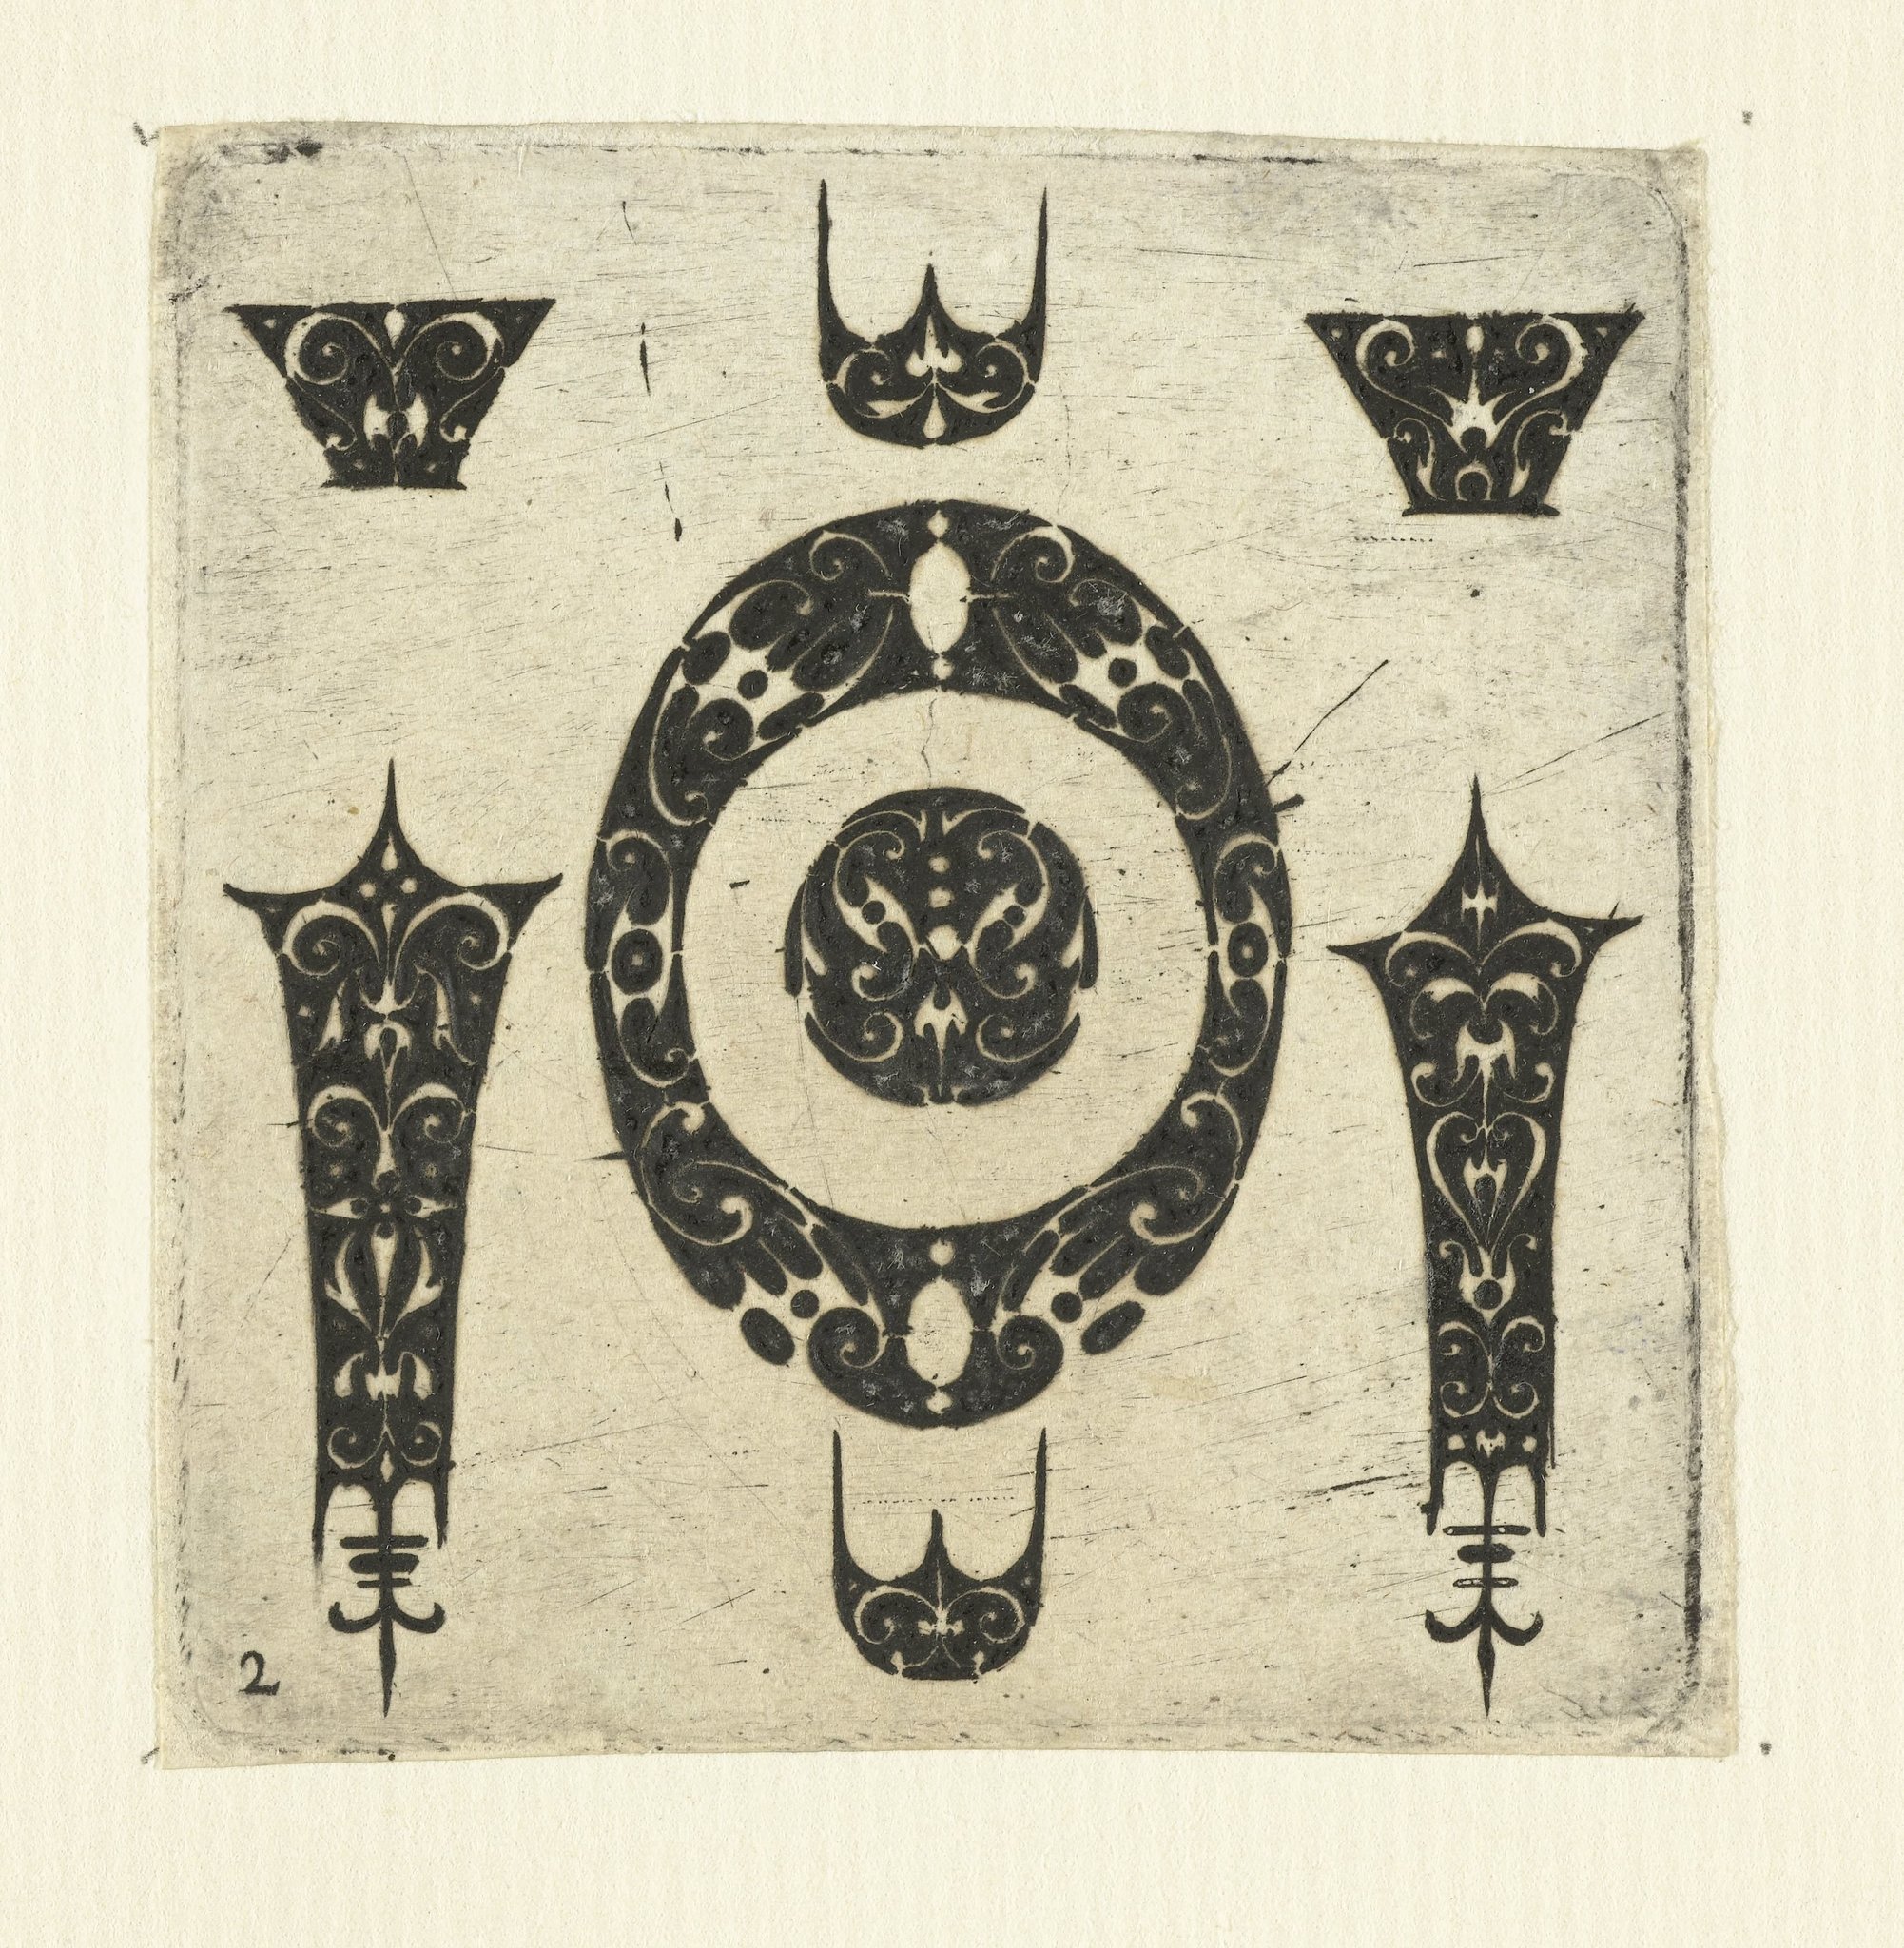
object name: print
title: Ontwerp voor ovale rand van wijzerplaat en zes ornamenten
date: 1612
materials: paper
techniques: engraving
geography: leiden